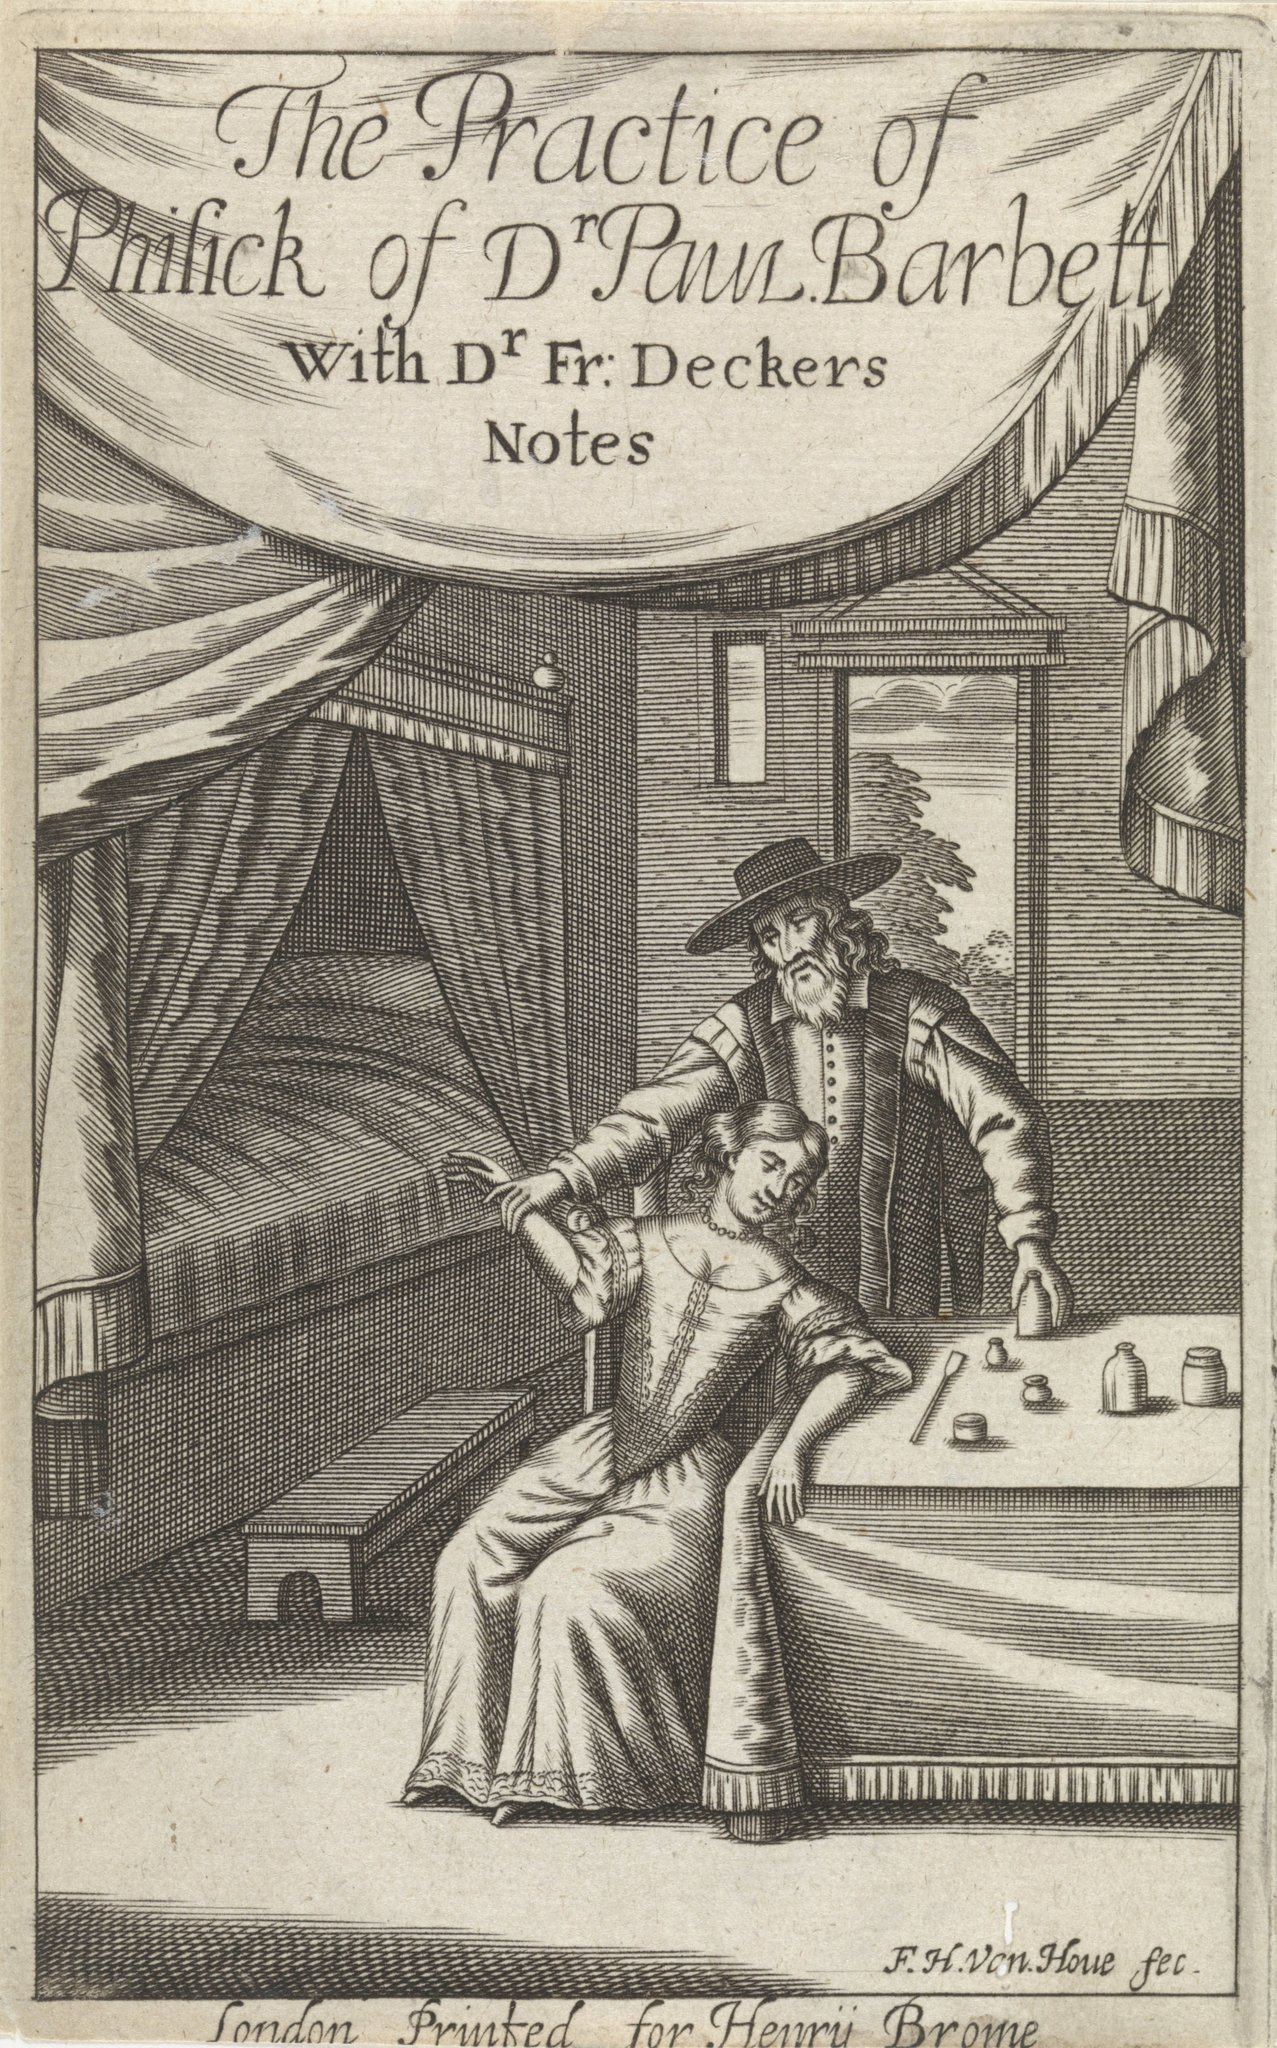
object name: print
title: Titelpagina voor: Dekkers, F., The Practice of Phisick of Dr. Paul Barbett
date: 1675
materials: paper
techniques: engraving, etching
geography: london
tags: physician, doctor, patient, sick person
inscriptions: collector's mark: Lugt 2228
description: Een dokter, Paulus Barbette, voelt een jonge vrouw die voor hem op een stoel zit bij haar pols. Op tafel staan verschillende flesjes en potjes. Links een bed.